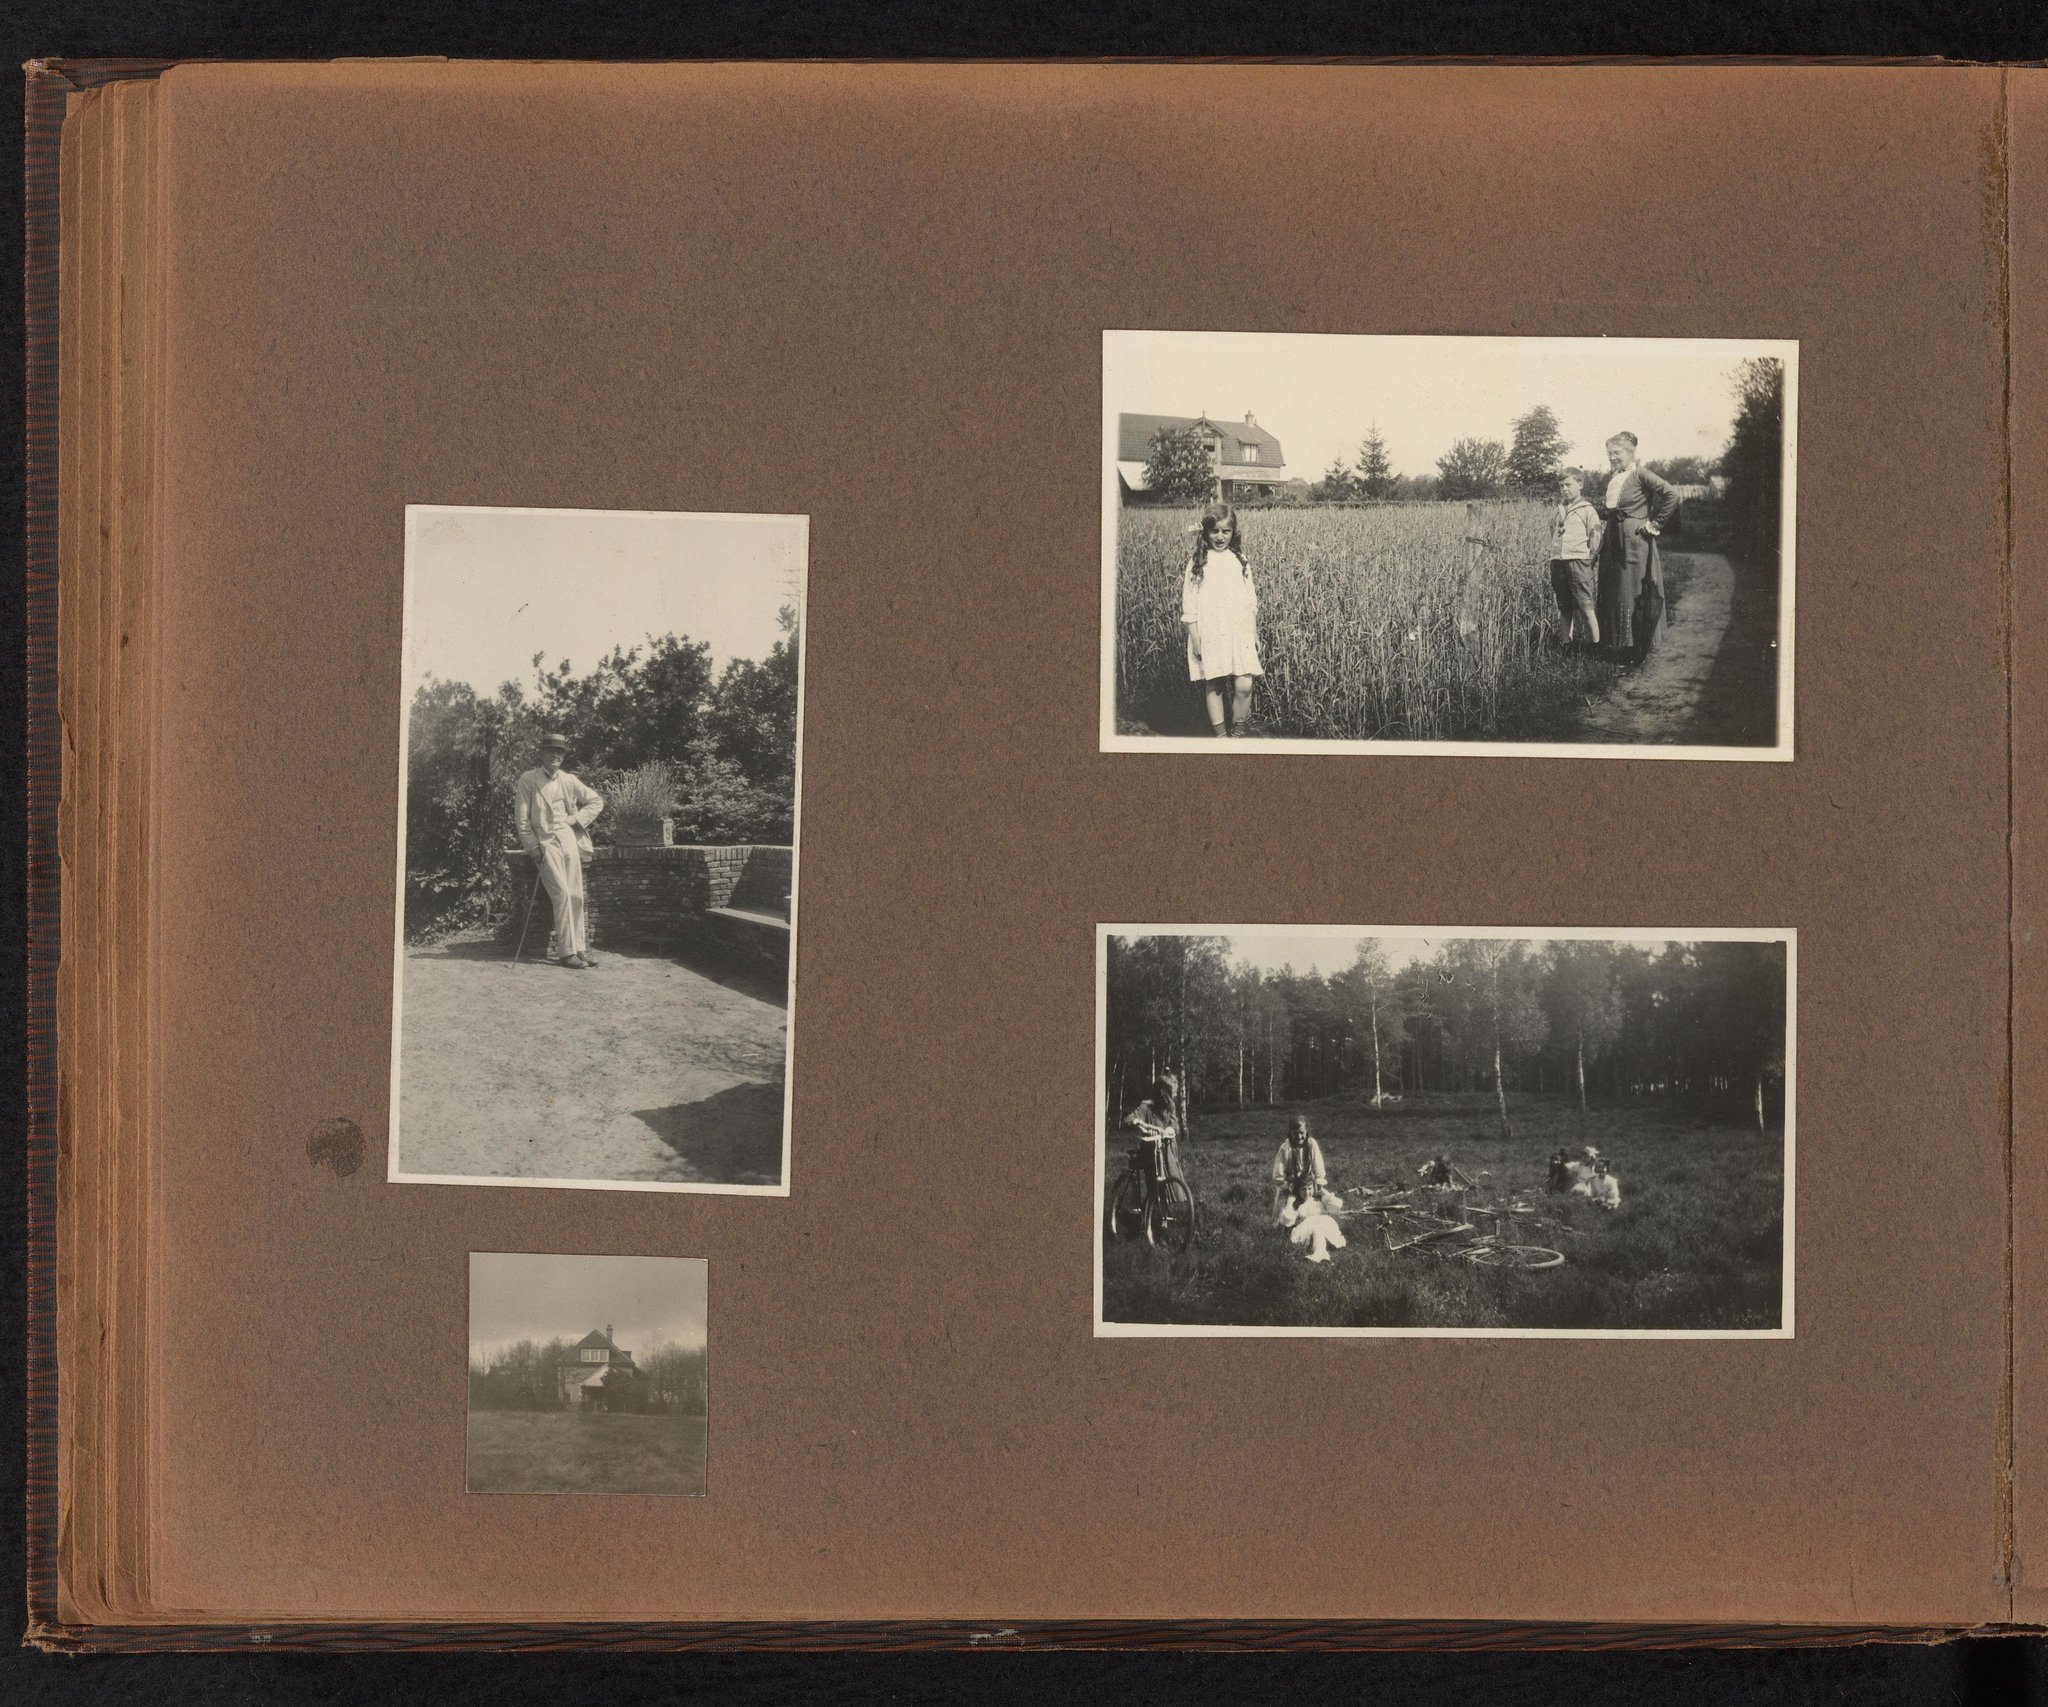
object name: photograph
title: Bladzijde uit het fotoalbum van de familie Diepenbrock met 4 foto's van Alphons Diepenbrock en zijn omgeving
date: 1909-1920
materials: cardboard, photographic support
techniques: photography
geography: amsterdam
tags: netherlands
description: Bruin albumblad 52 van familiealbum van Alphons Diepenbrock.